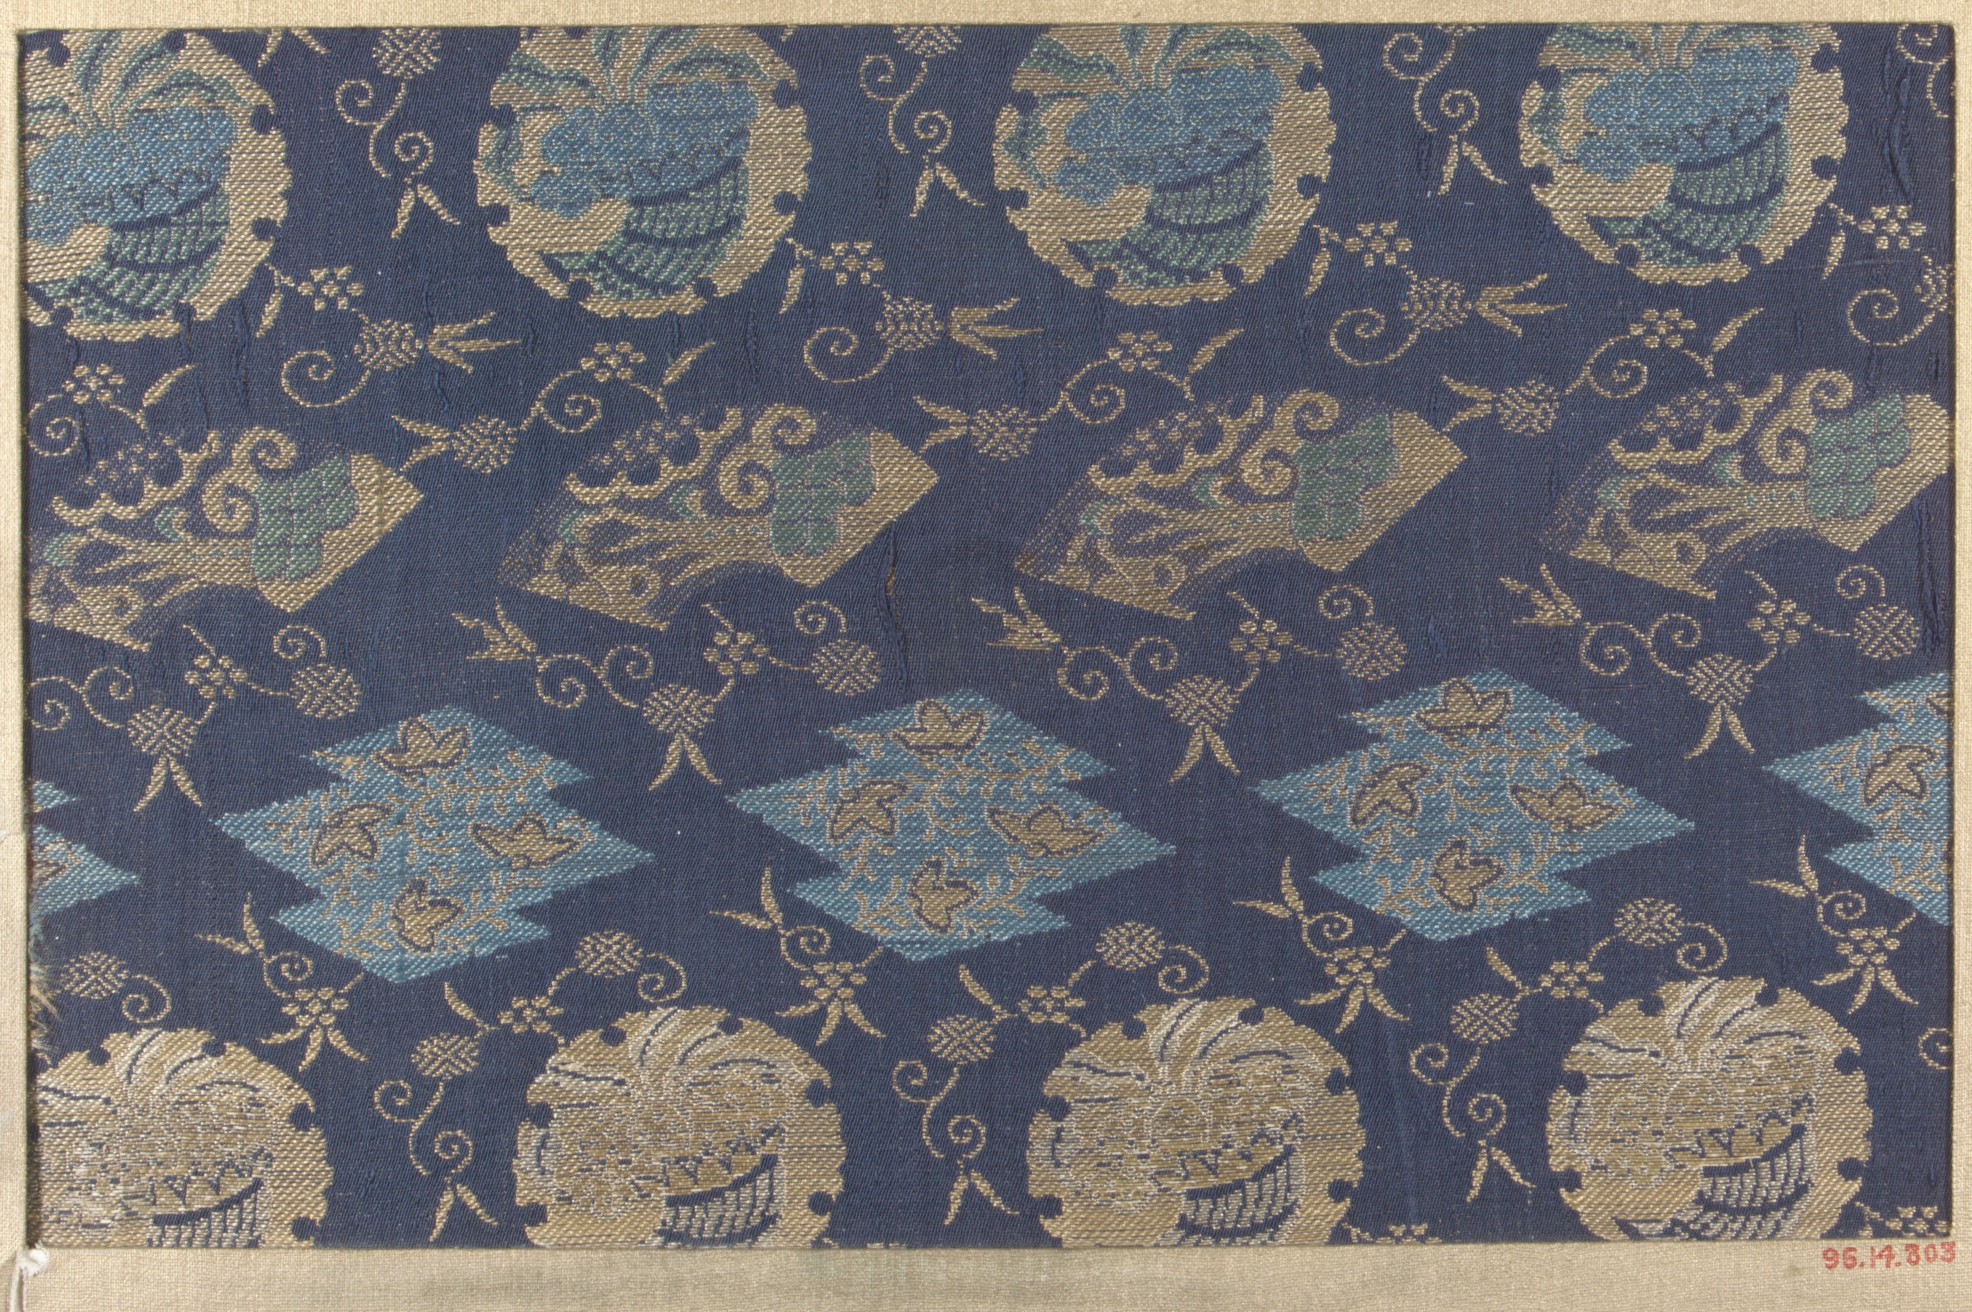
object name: piece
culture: japanese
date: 1701-1900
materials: silk